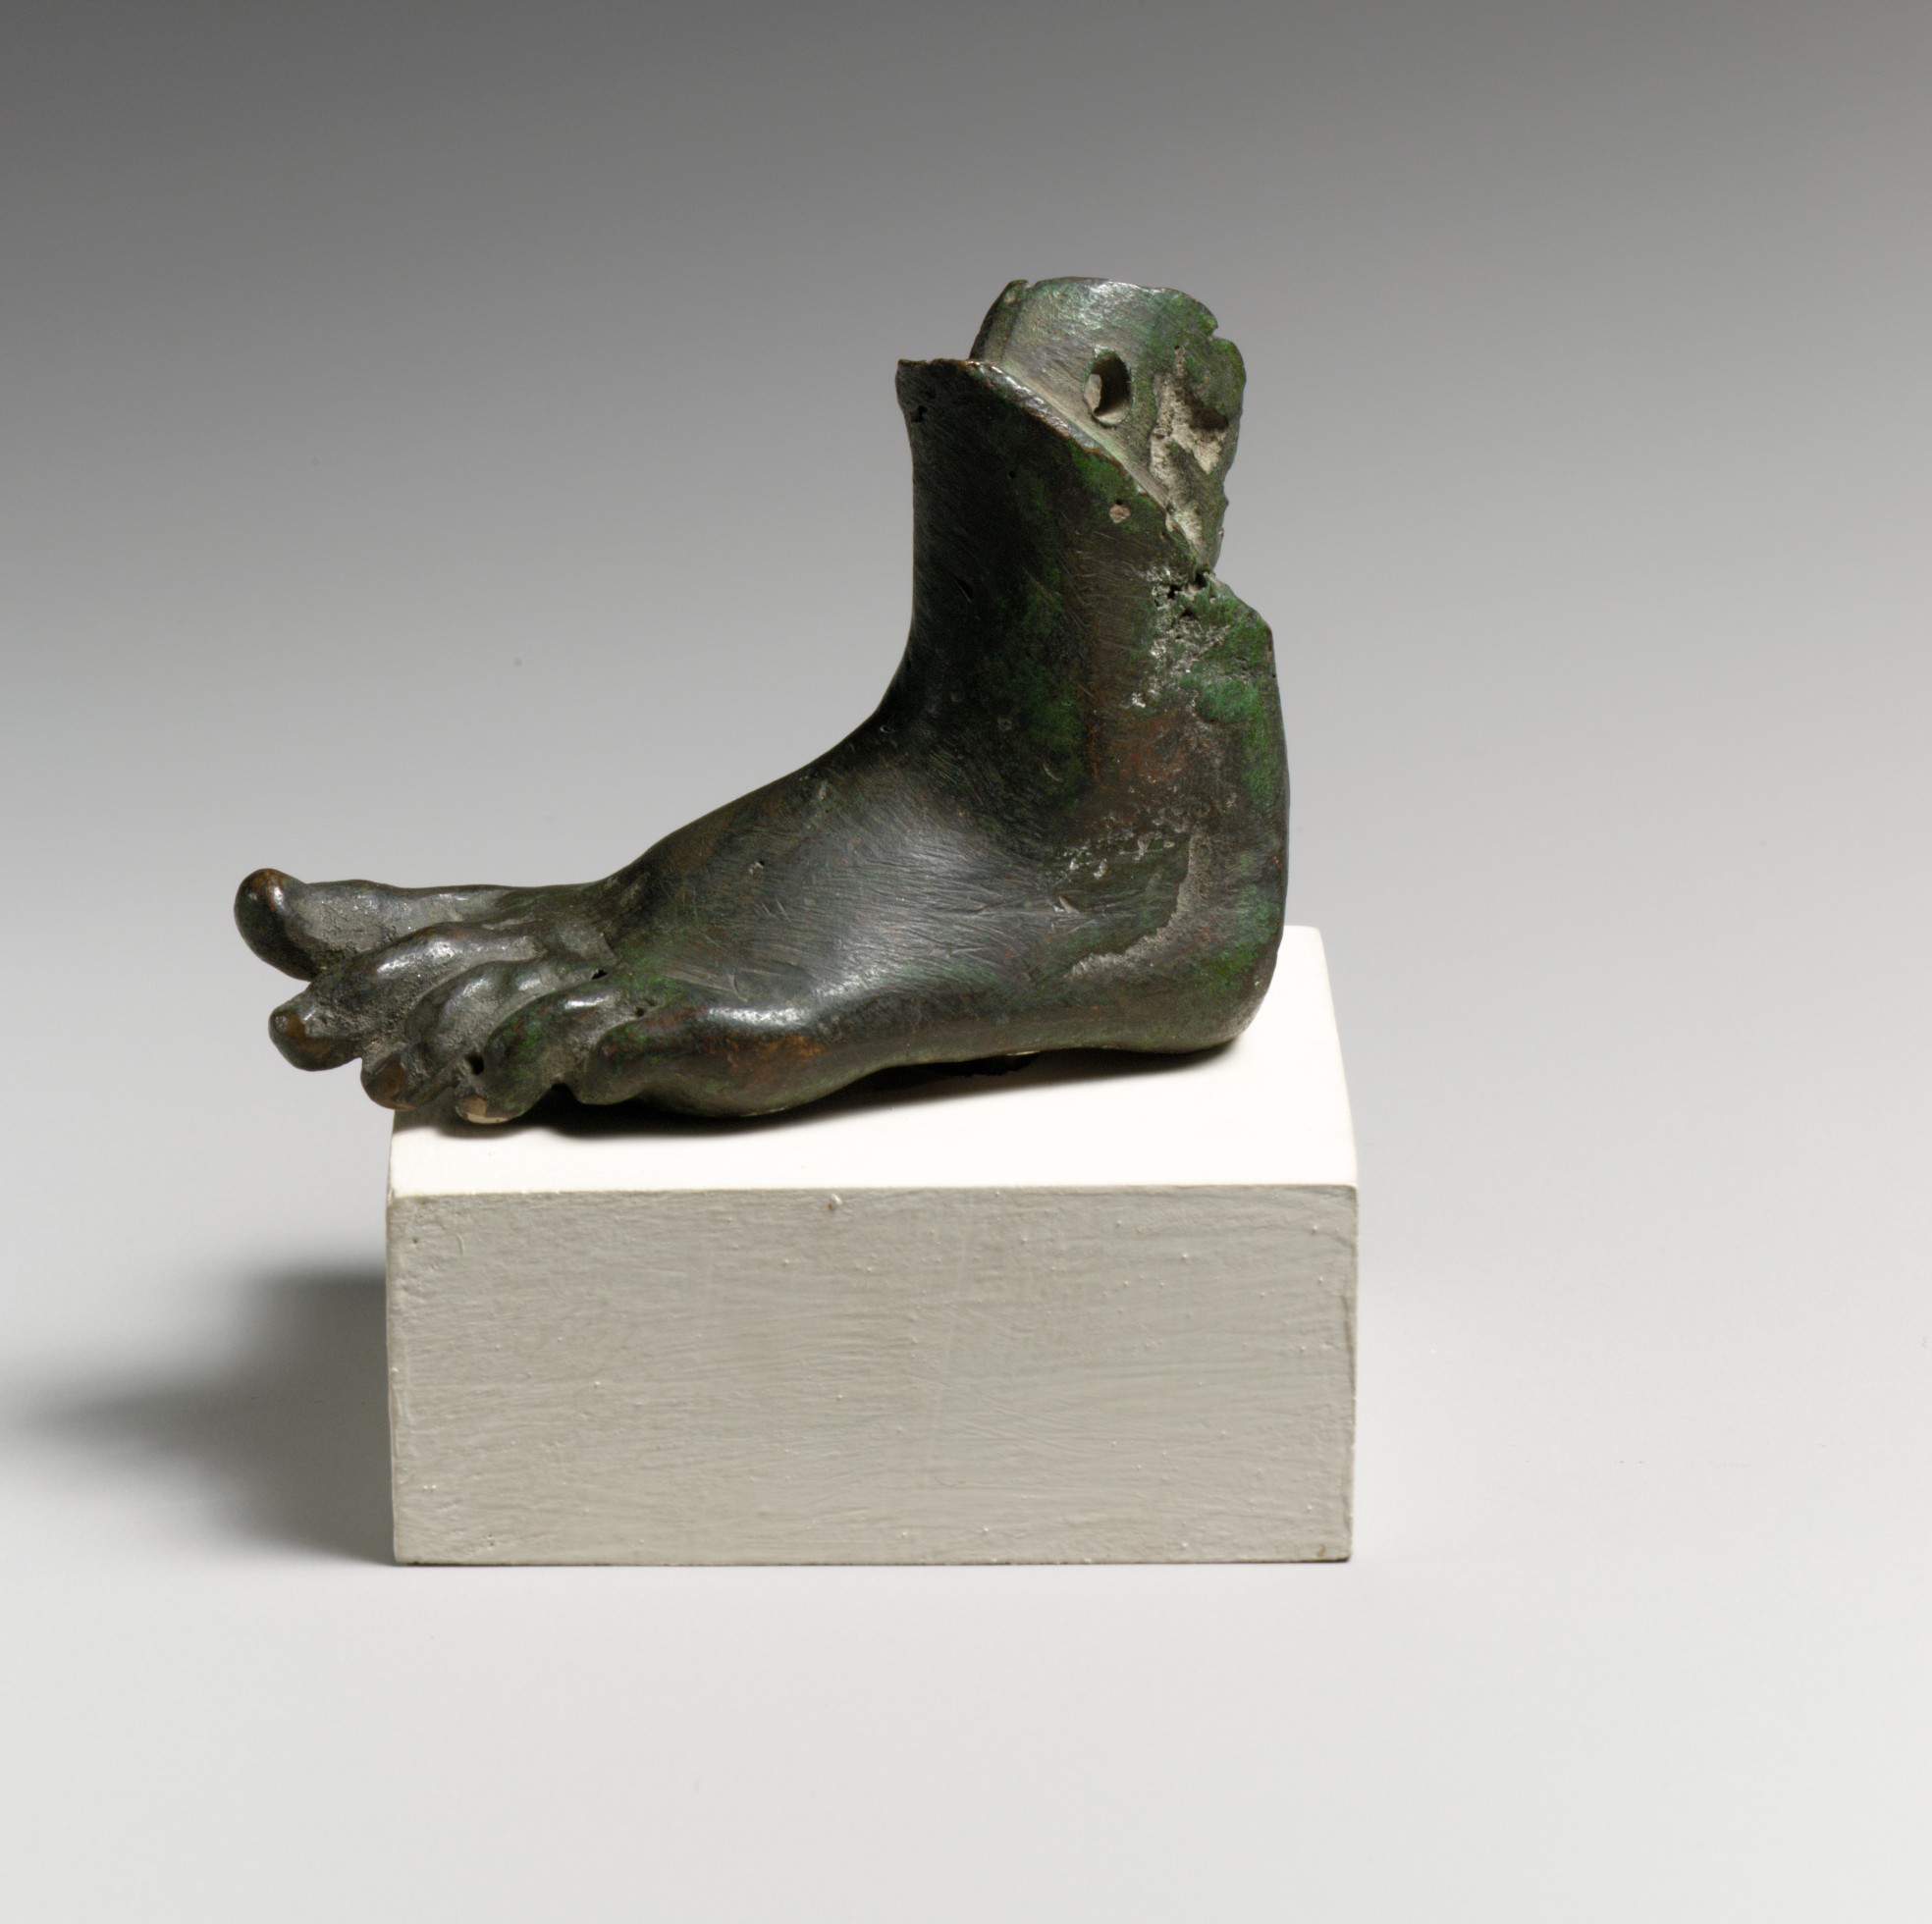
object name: foot fragment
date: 7000 BCE-330 CE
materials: bronze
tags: feet